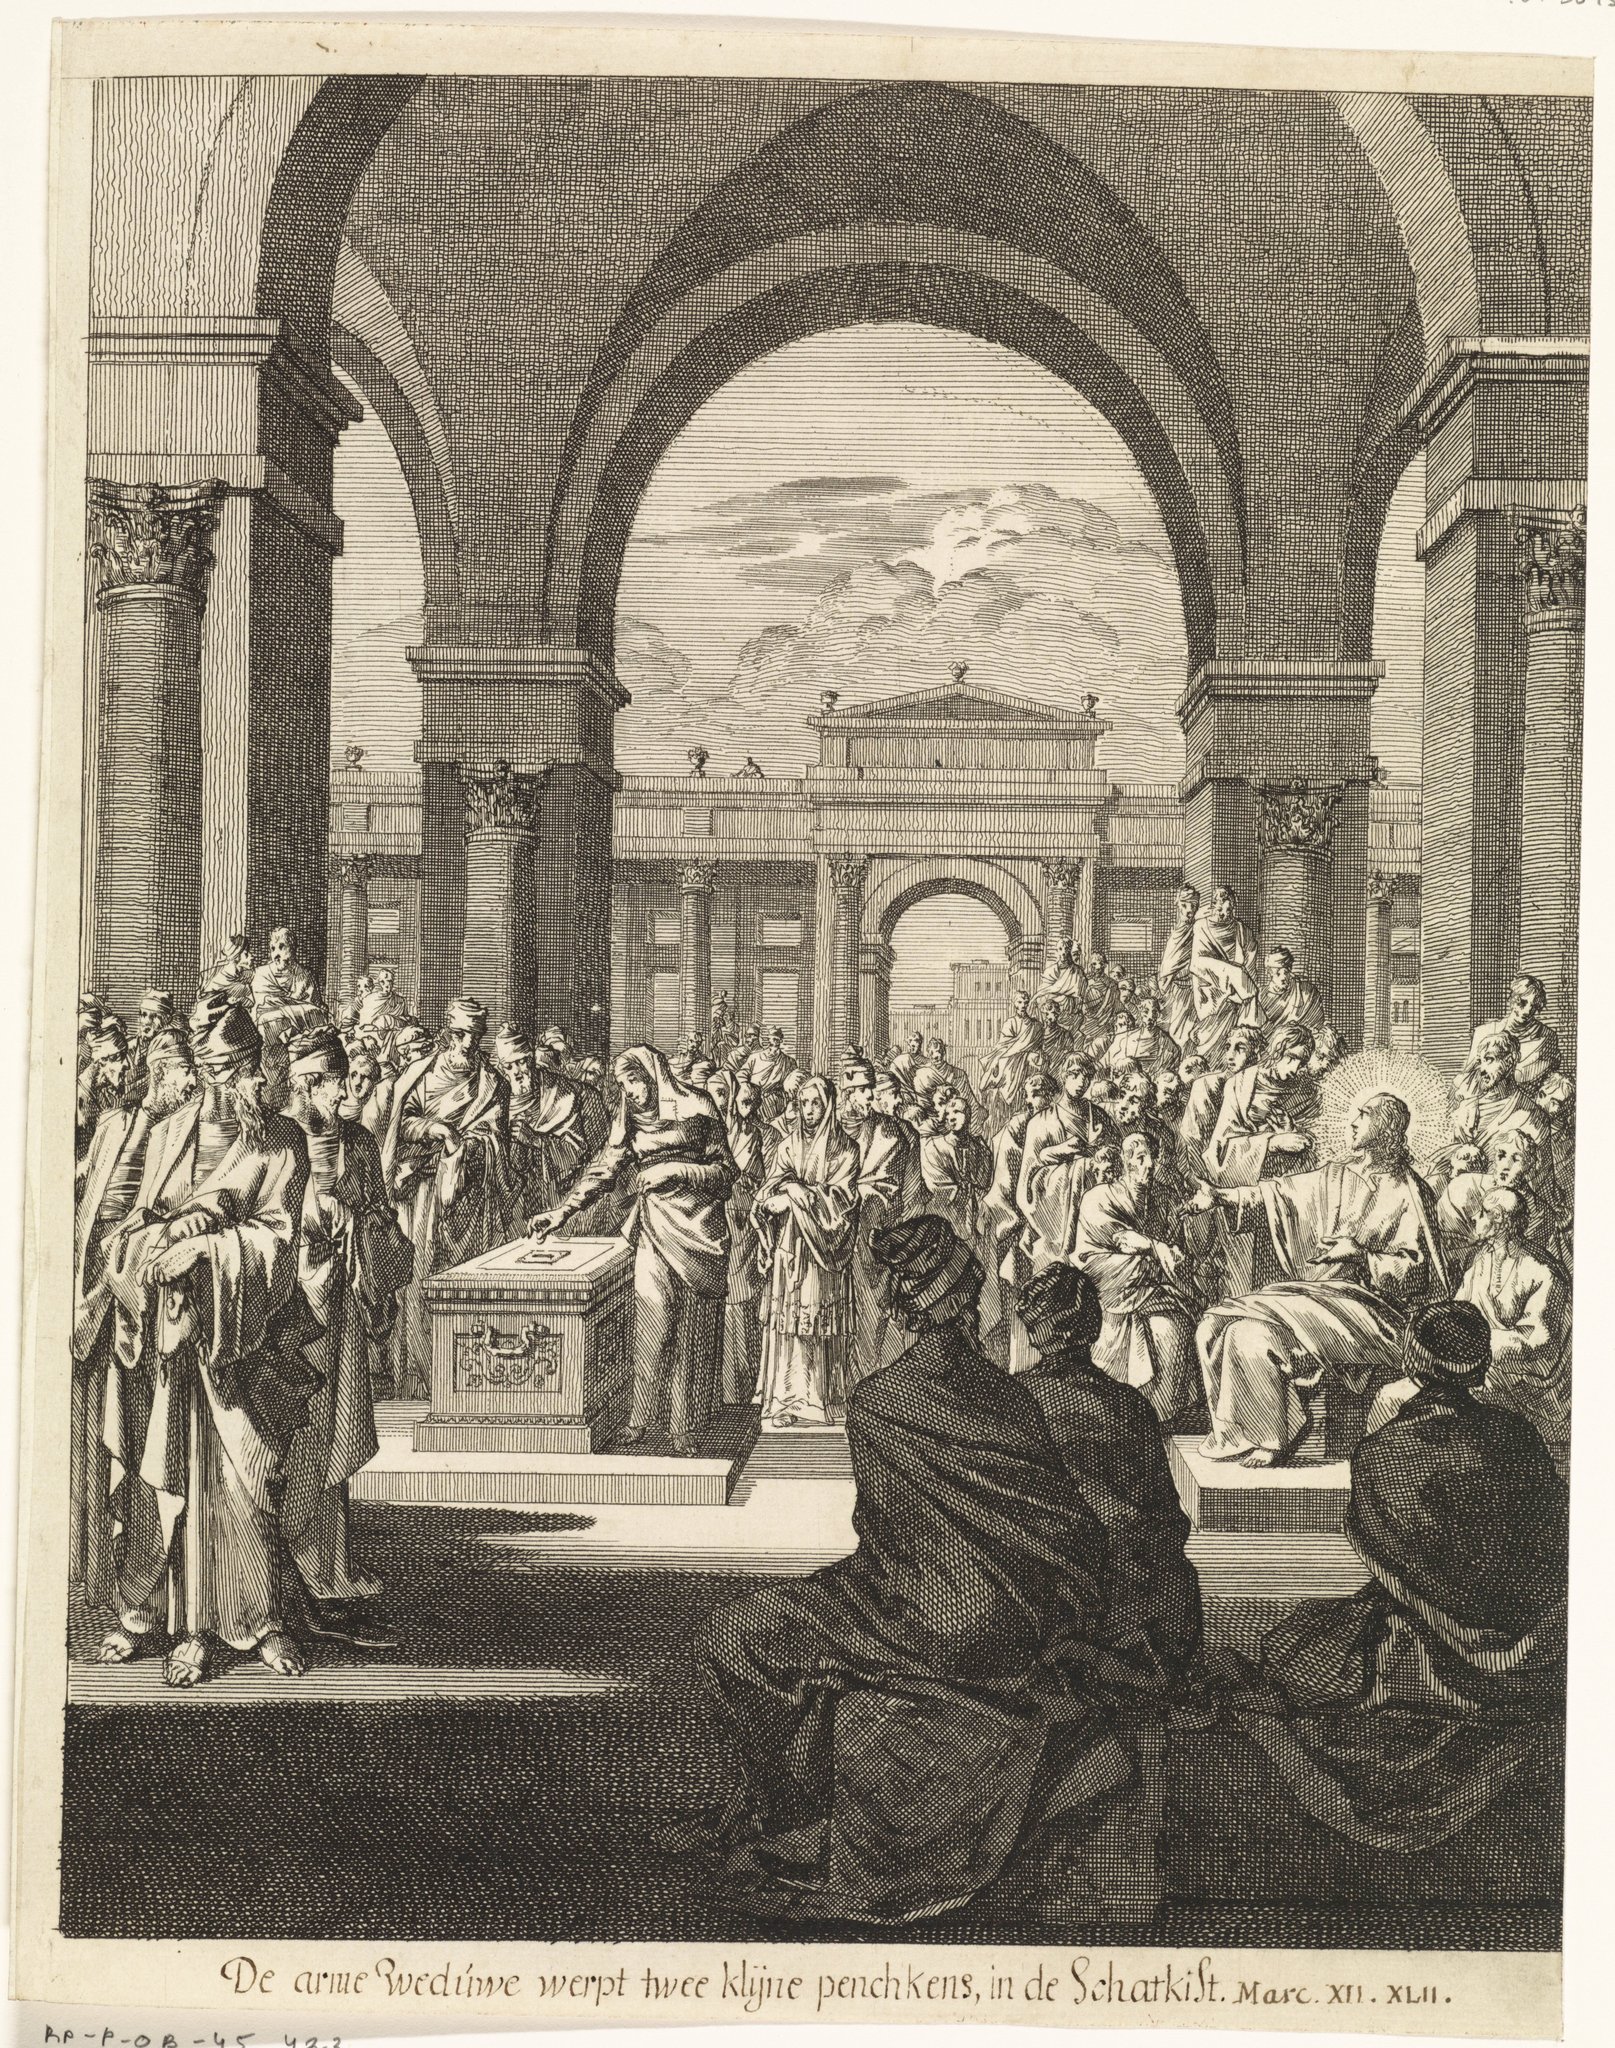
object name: print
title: Vrijgevigheid van de arme weduwe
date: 1708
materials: paper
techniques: etching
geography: amsterdam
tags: the widow's mite: christ draws the disciples' attention to a woman who puts a few coins in the temple's money chest (mark 12:41-44; luke 21:1-4)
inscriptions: collector's mark: Lugt 2228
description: Proefdruk van een prent welke is opgenomen als illustratie in: Historiae Celebriores Veteris Testamenti. Christoph Weigel, 1708.